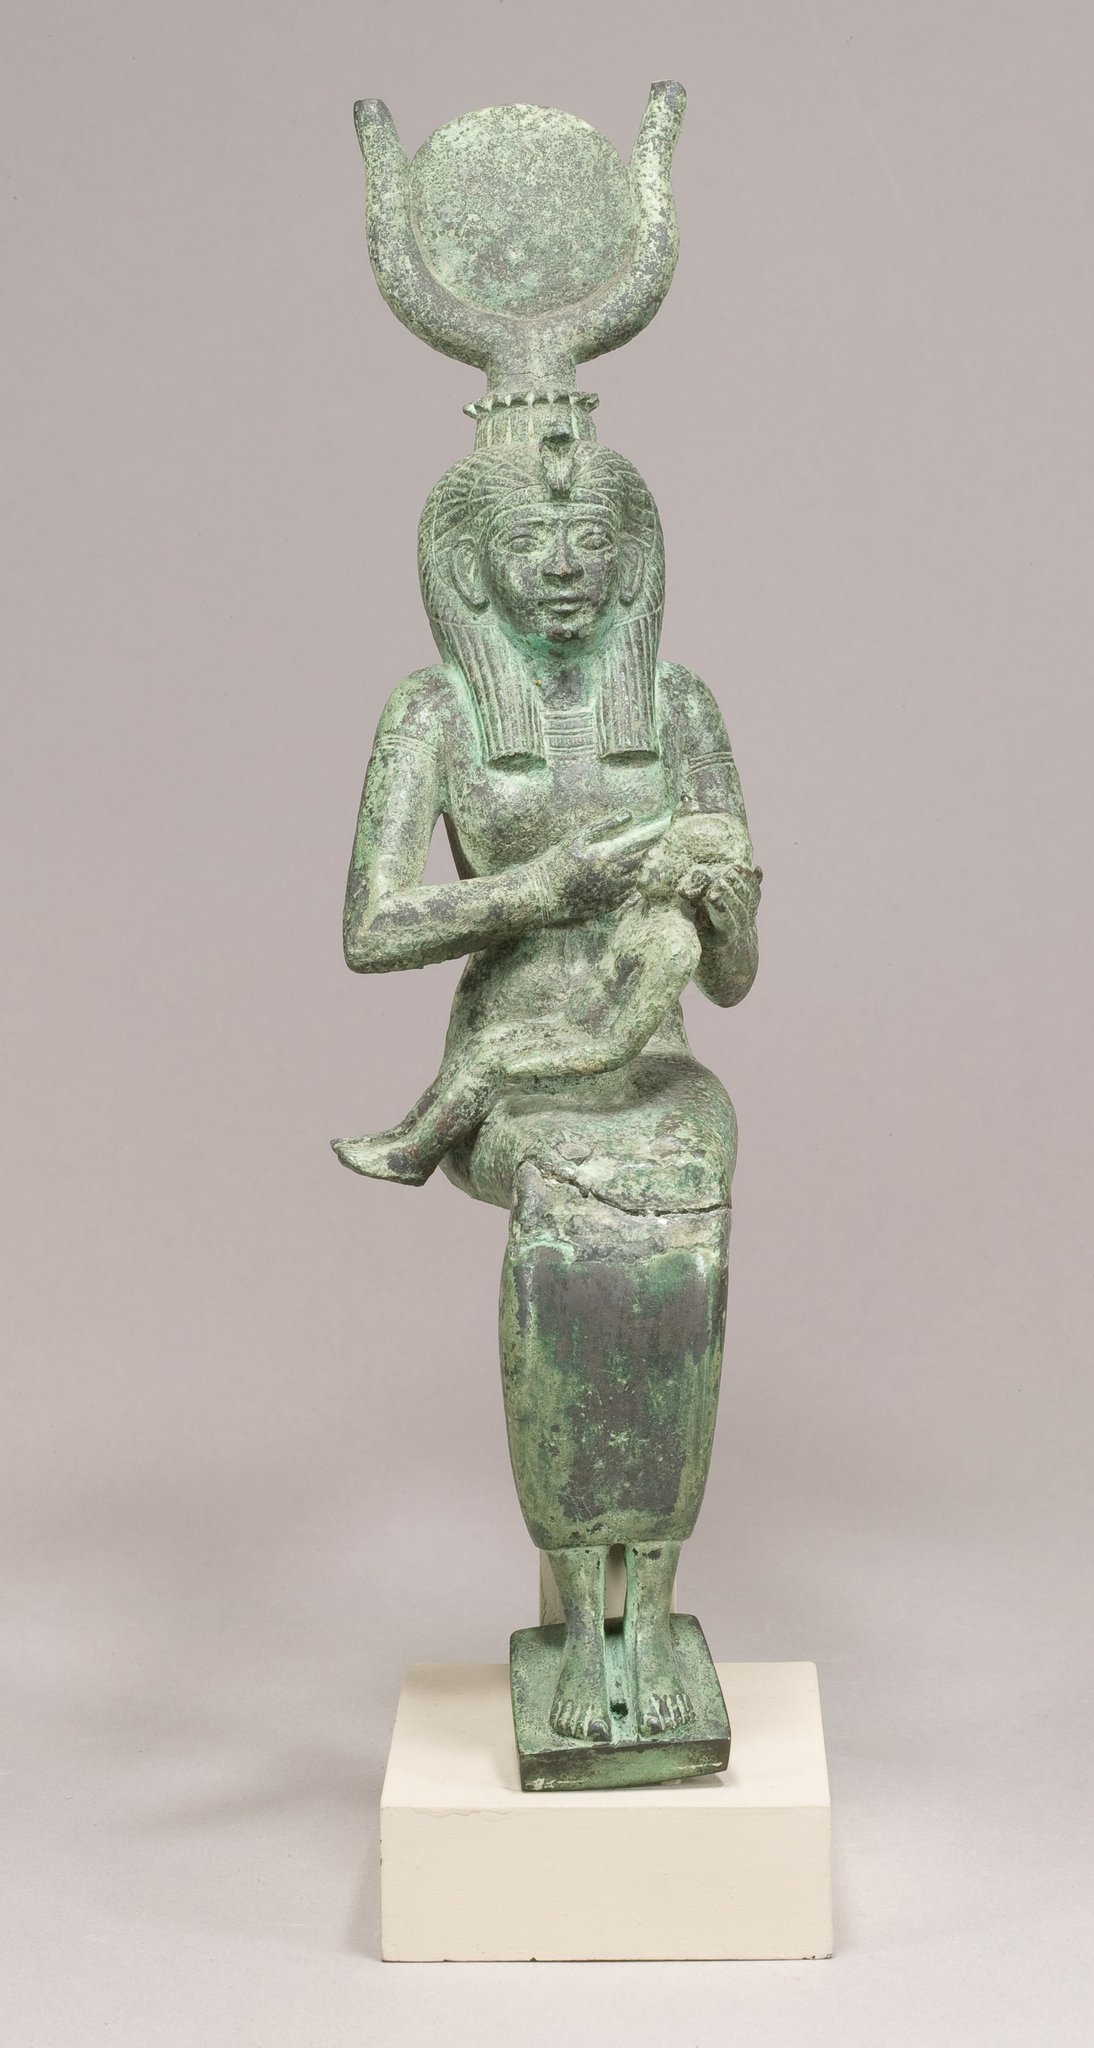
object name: statuette, isi, horus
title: Statuette, Isis, Horus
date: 664-332 BCE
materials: bronze, copper alloy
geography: egypt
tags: horus,isis